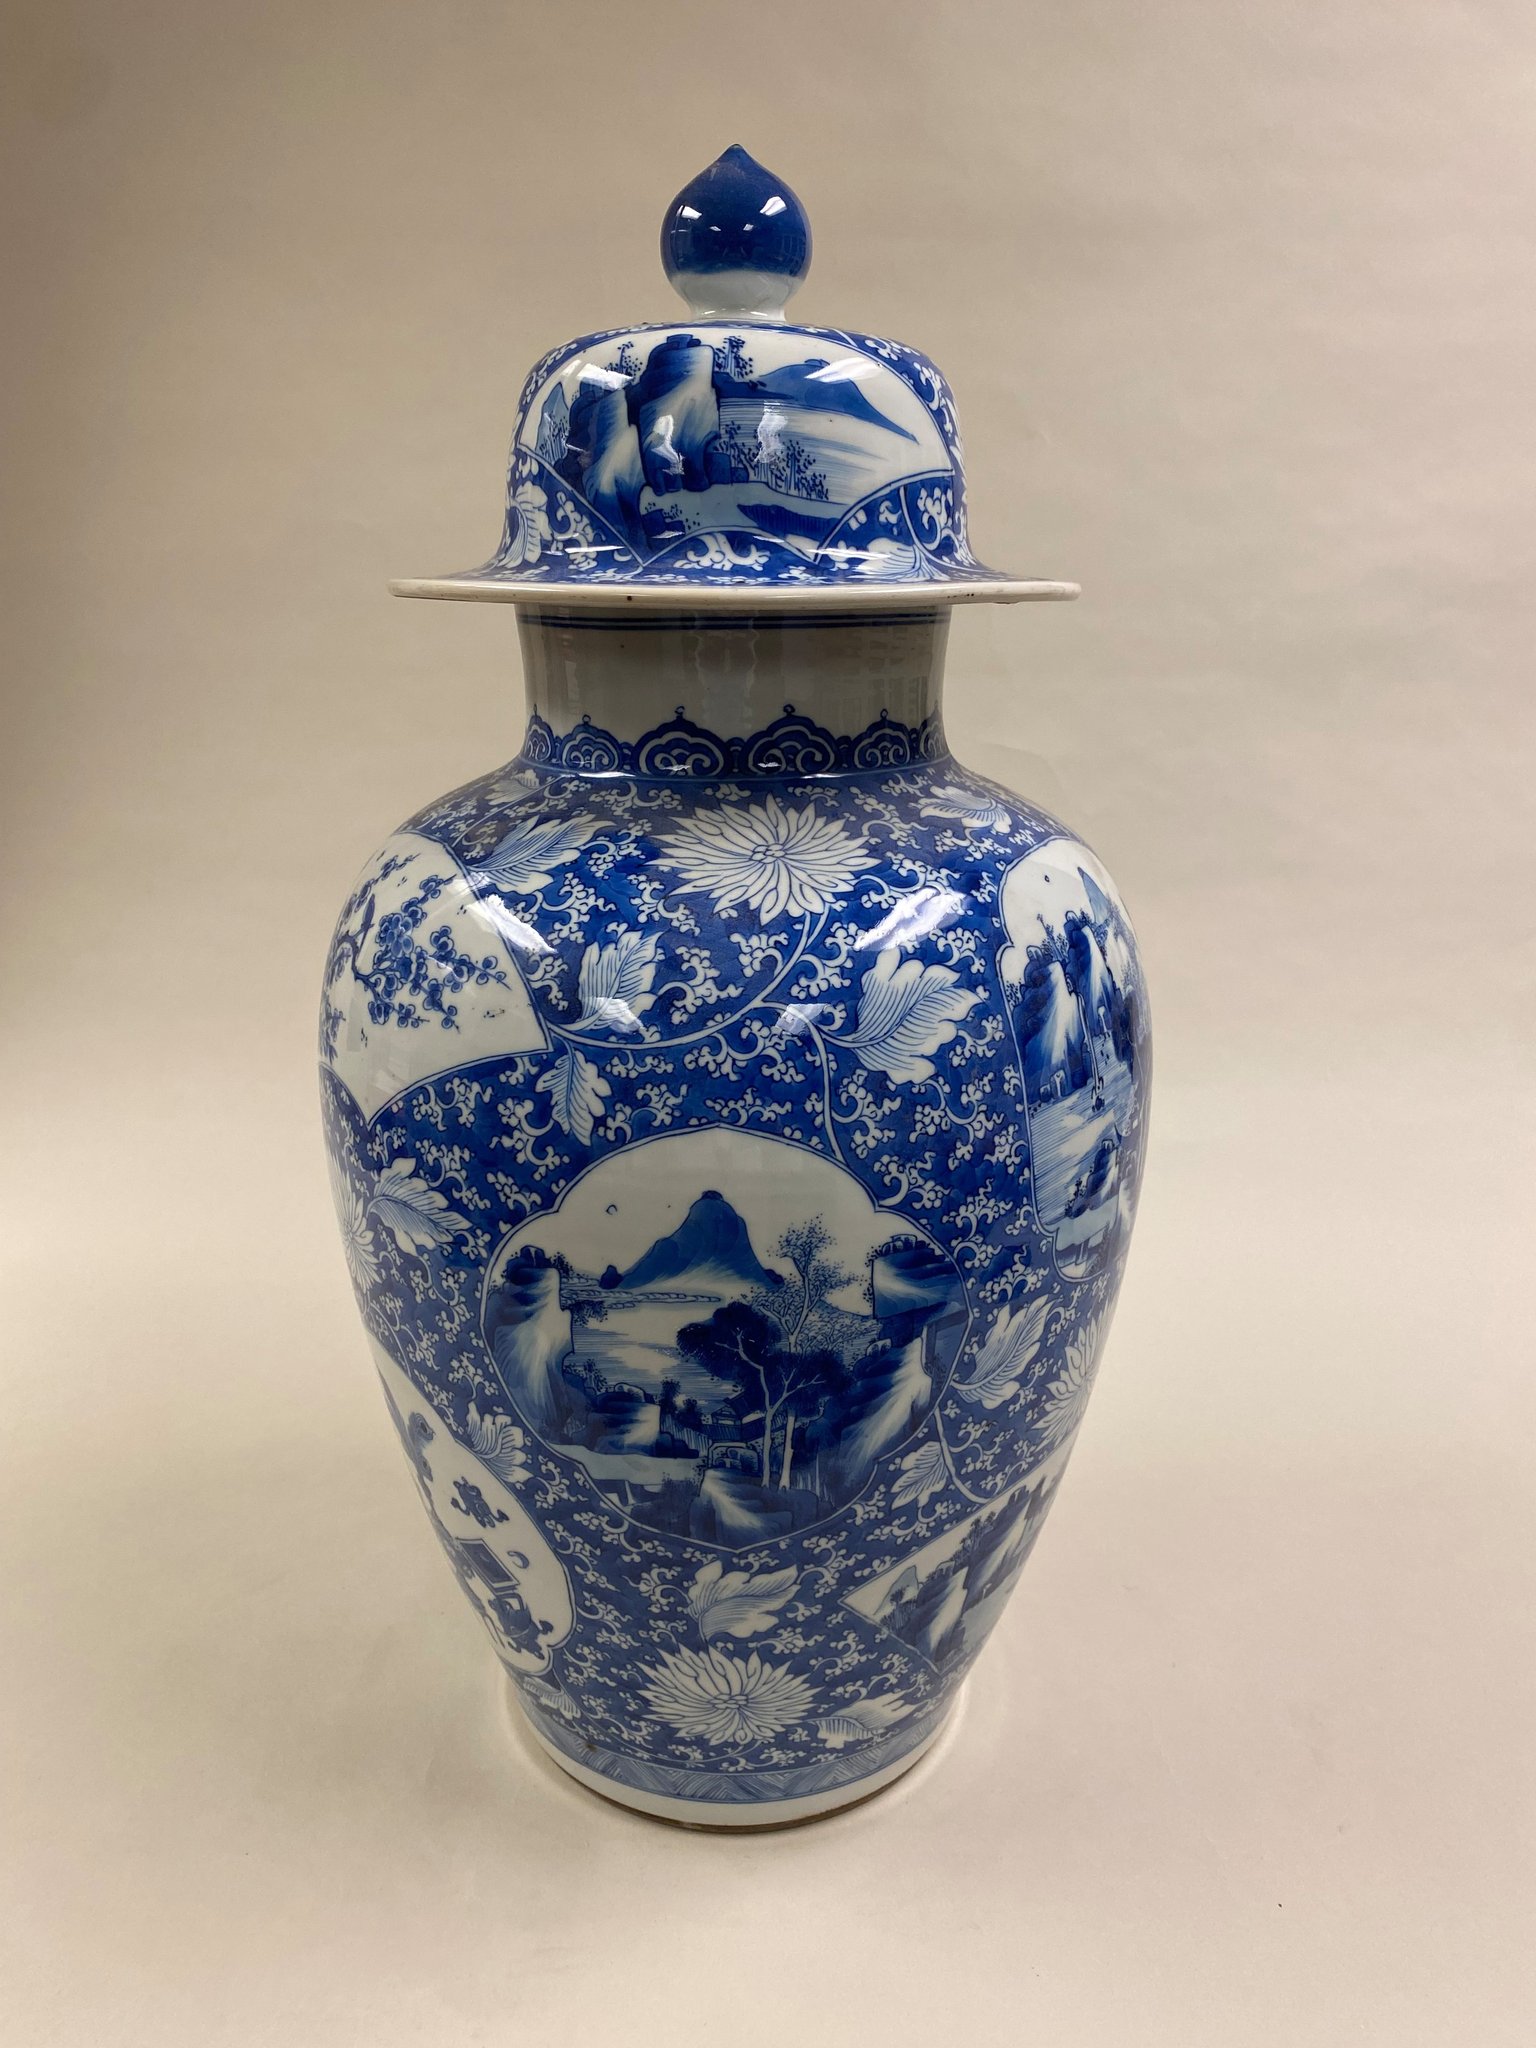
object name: covered jar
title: Covered jar with flowers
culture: chinese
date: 1667-1733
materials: cobalt, porcelain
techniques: painting, underglaze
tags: flowers